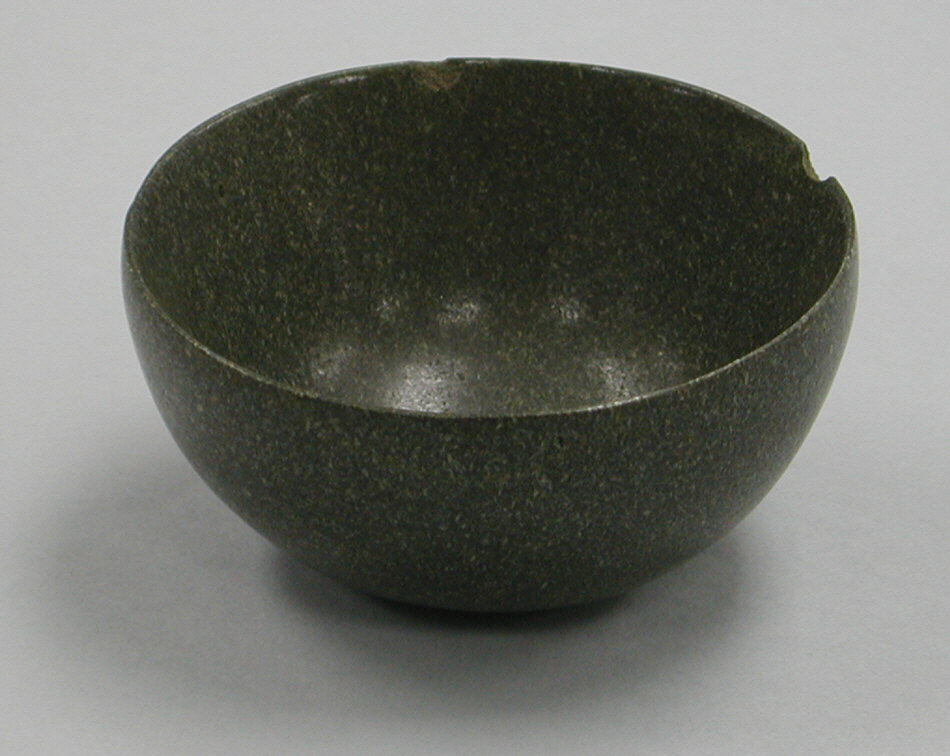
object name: bowl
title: Stone Bowl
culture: mexican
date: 1501-1600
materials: stone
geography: mexico